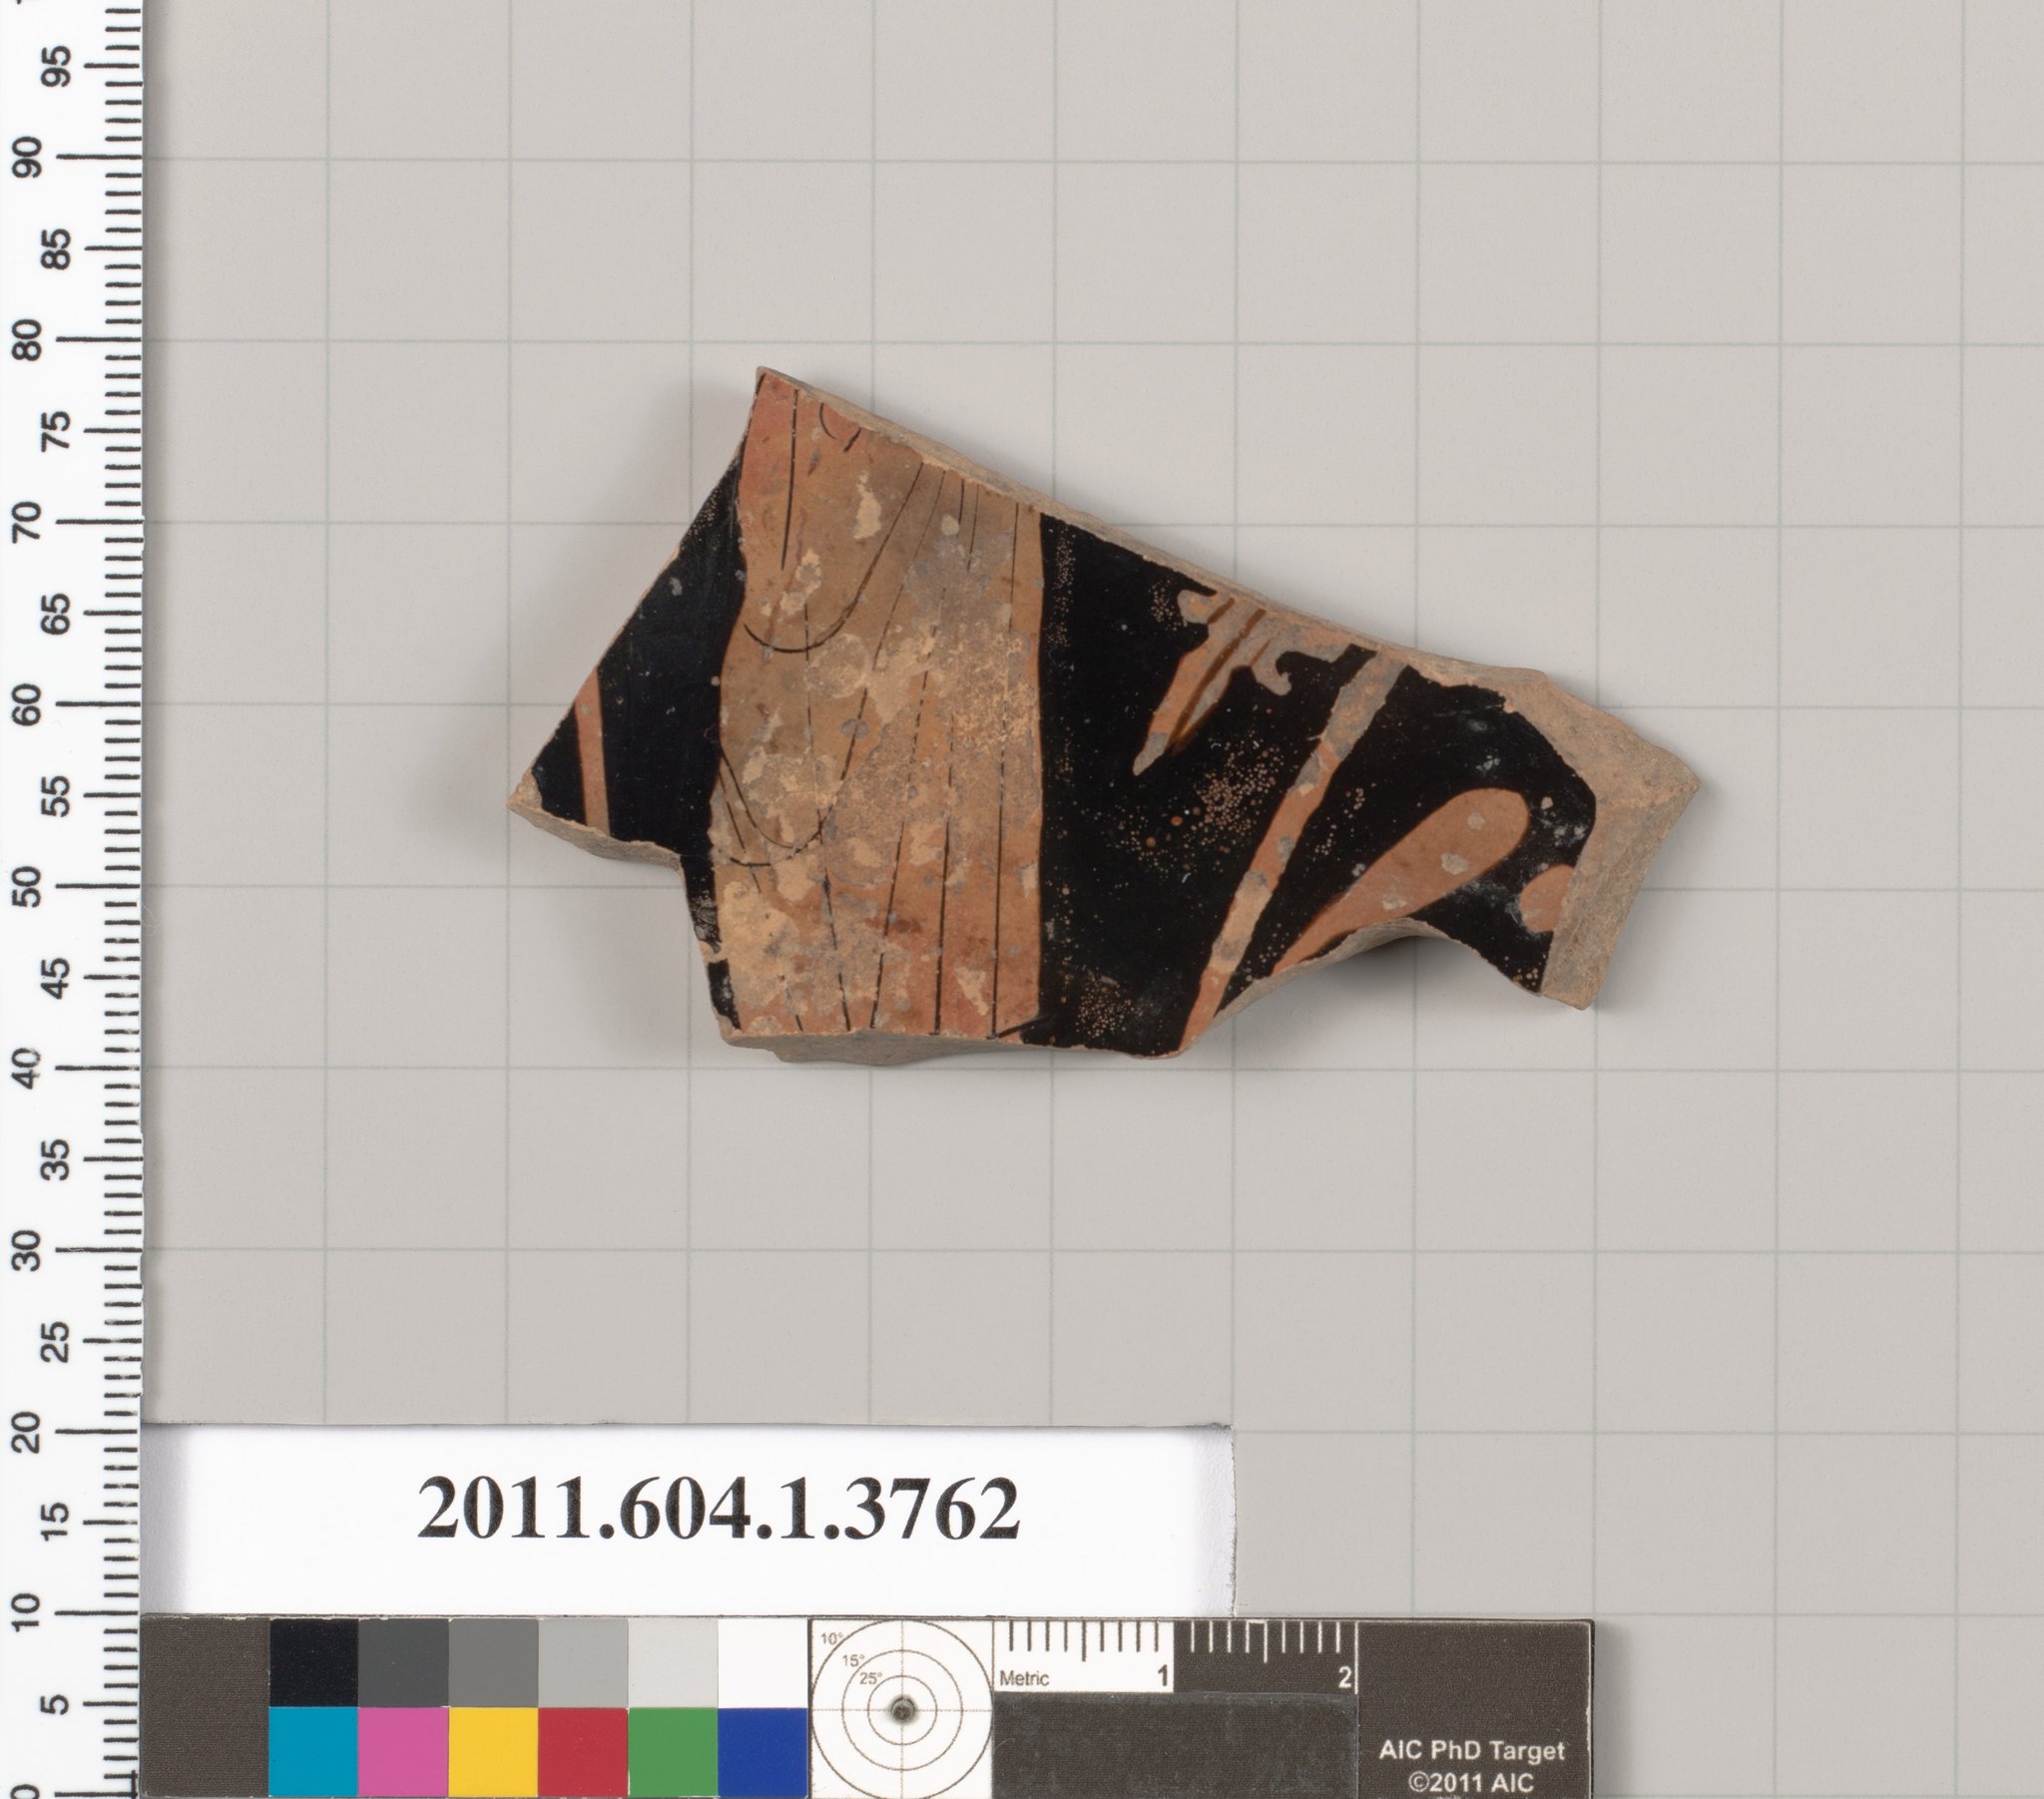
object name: kylix fragment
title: Terracotta fragment of a kylix (drinking cup)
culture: greek, attic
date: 475-451 BCE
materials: terracotta